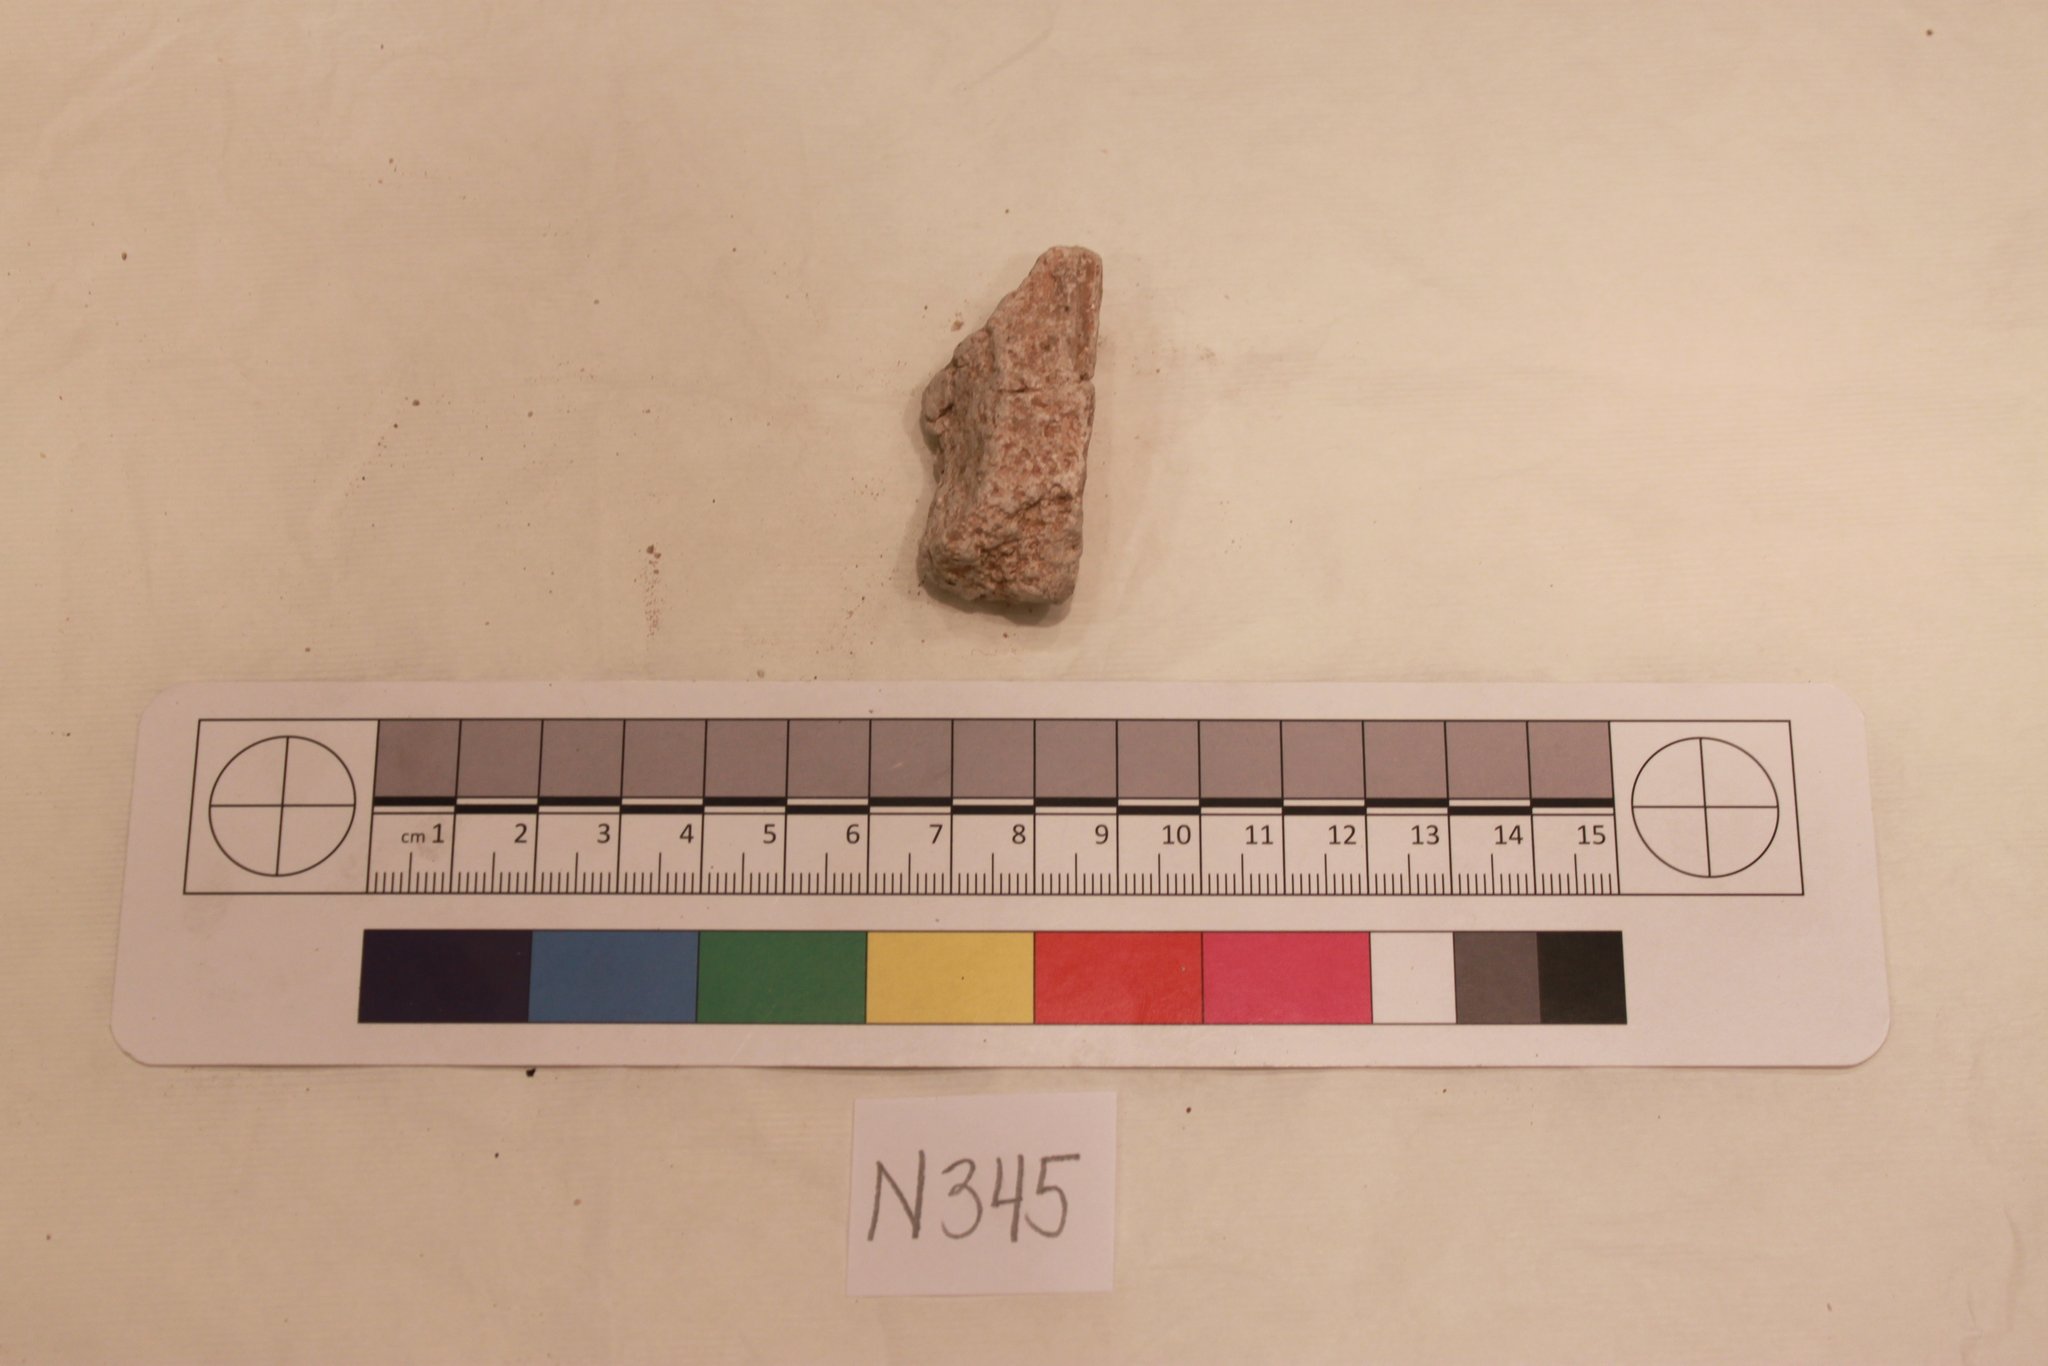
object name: fragment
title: Stucco Fragment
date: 701-1200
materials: plaster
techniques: carving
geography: iran